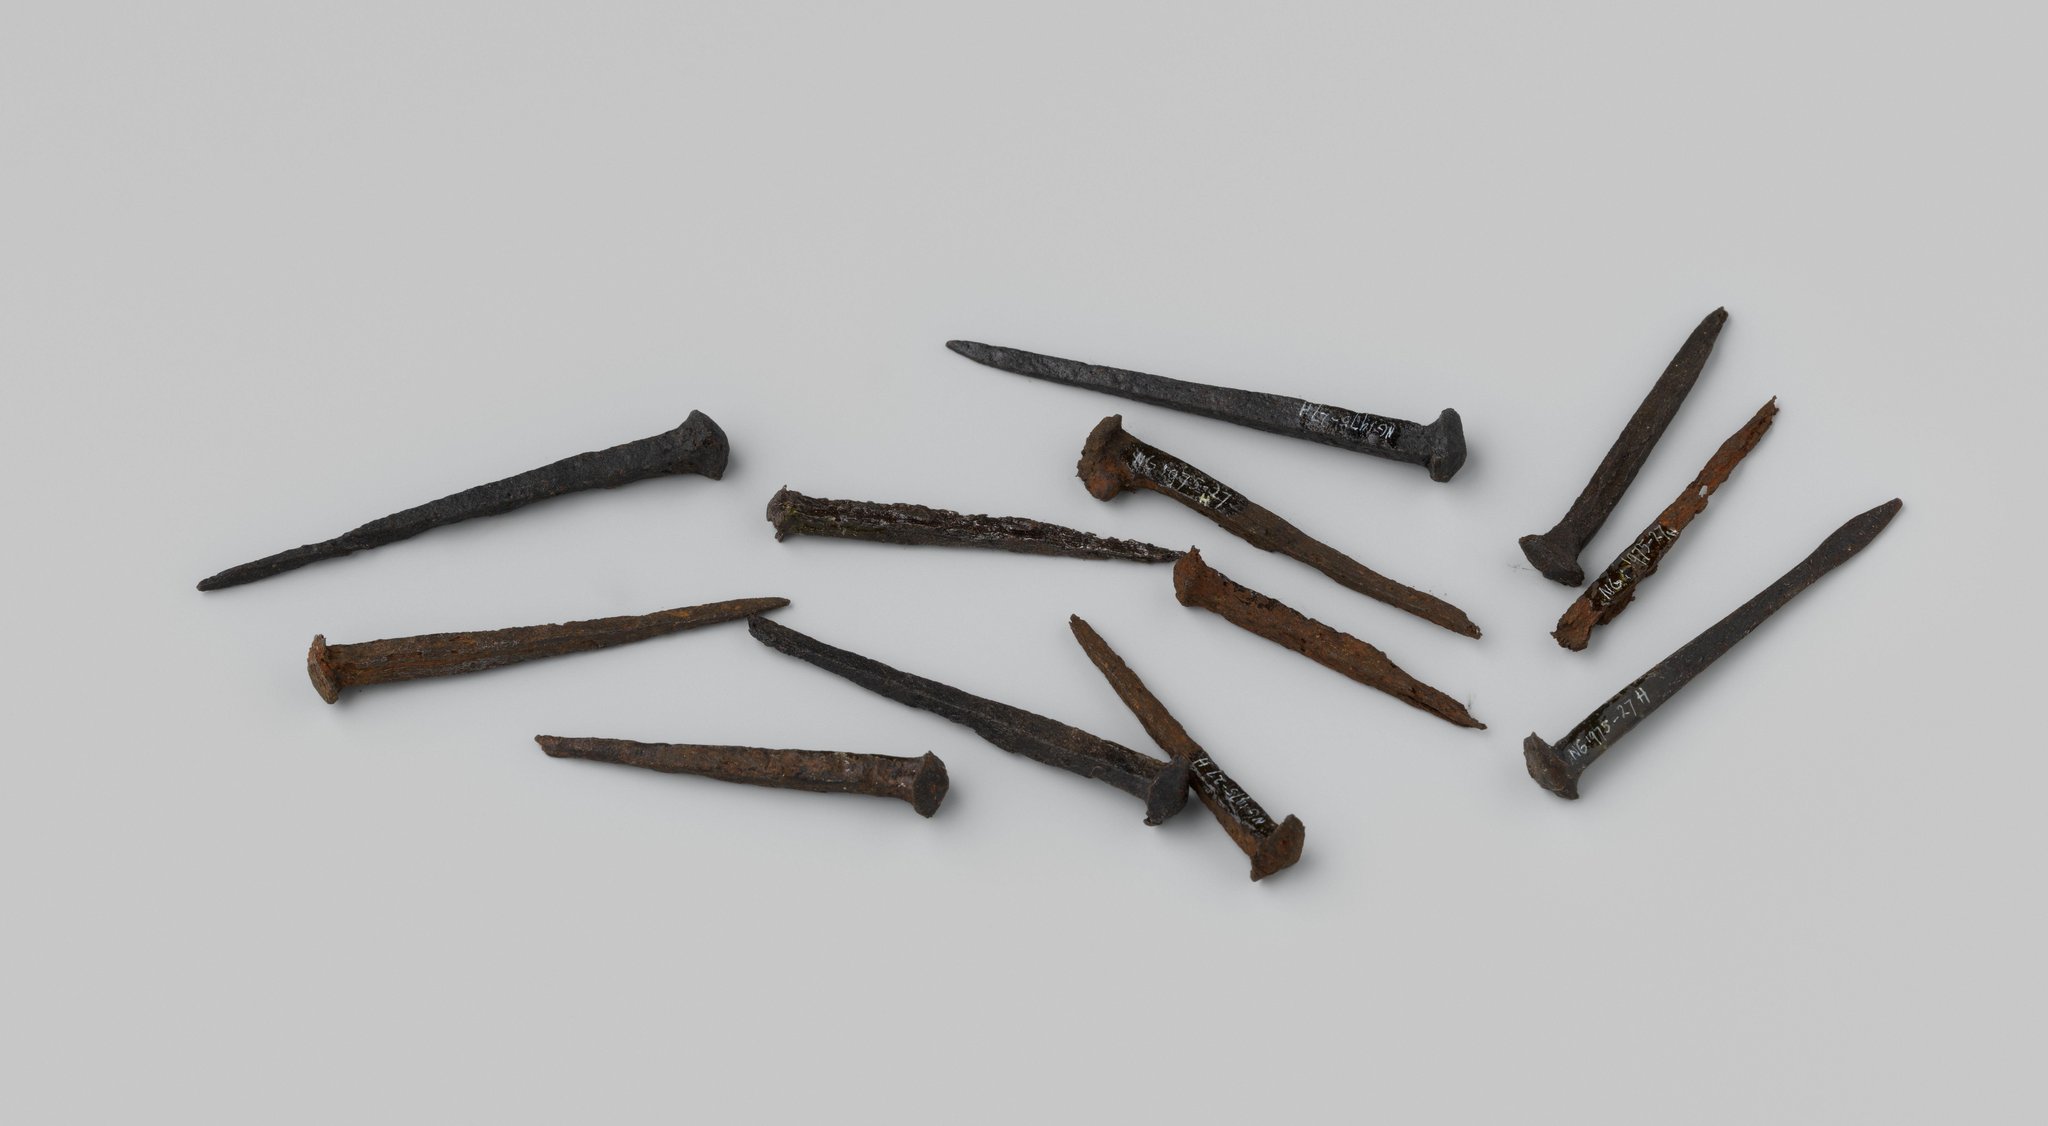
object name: nagel, spijker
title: Spijkers uit het wrak van de Oost-Indiëvaarder Hollandia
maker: Anonymous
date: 1700-1743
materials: iron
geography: netherlands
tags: verenigde oostindische compagnie, hollandia (schip), annet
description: Vierhoekige spits toelopende spjikers met kop.